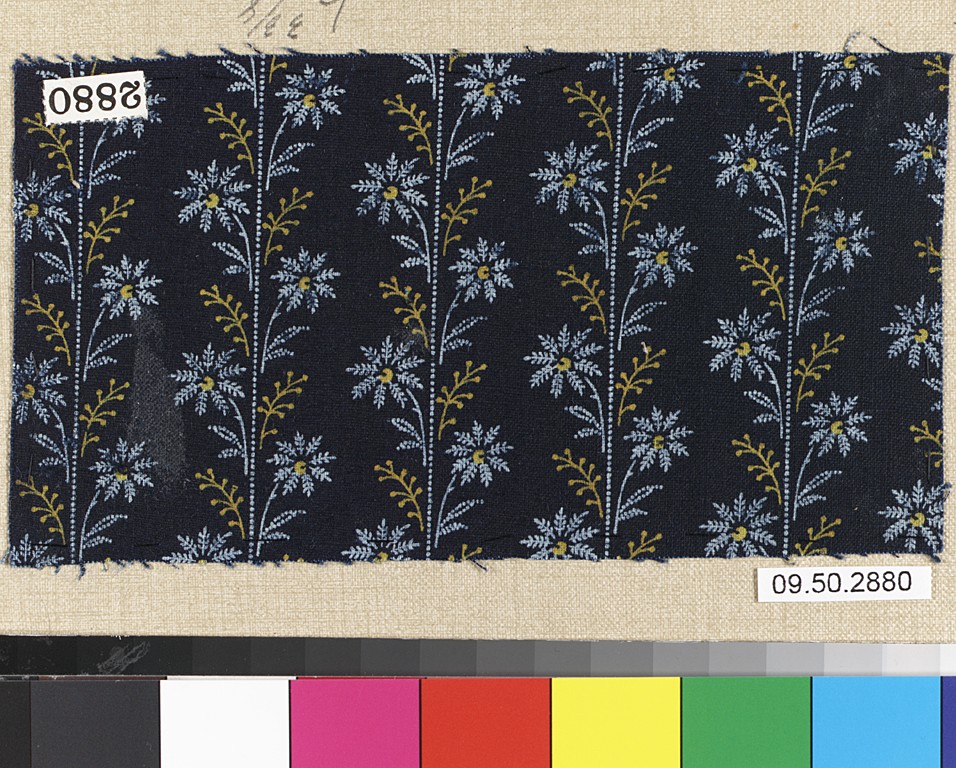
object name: piece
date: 1801-1900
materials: cotton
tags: flowers,leaves